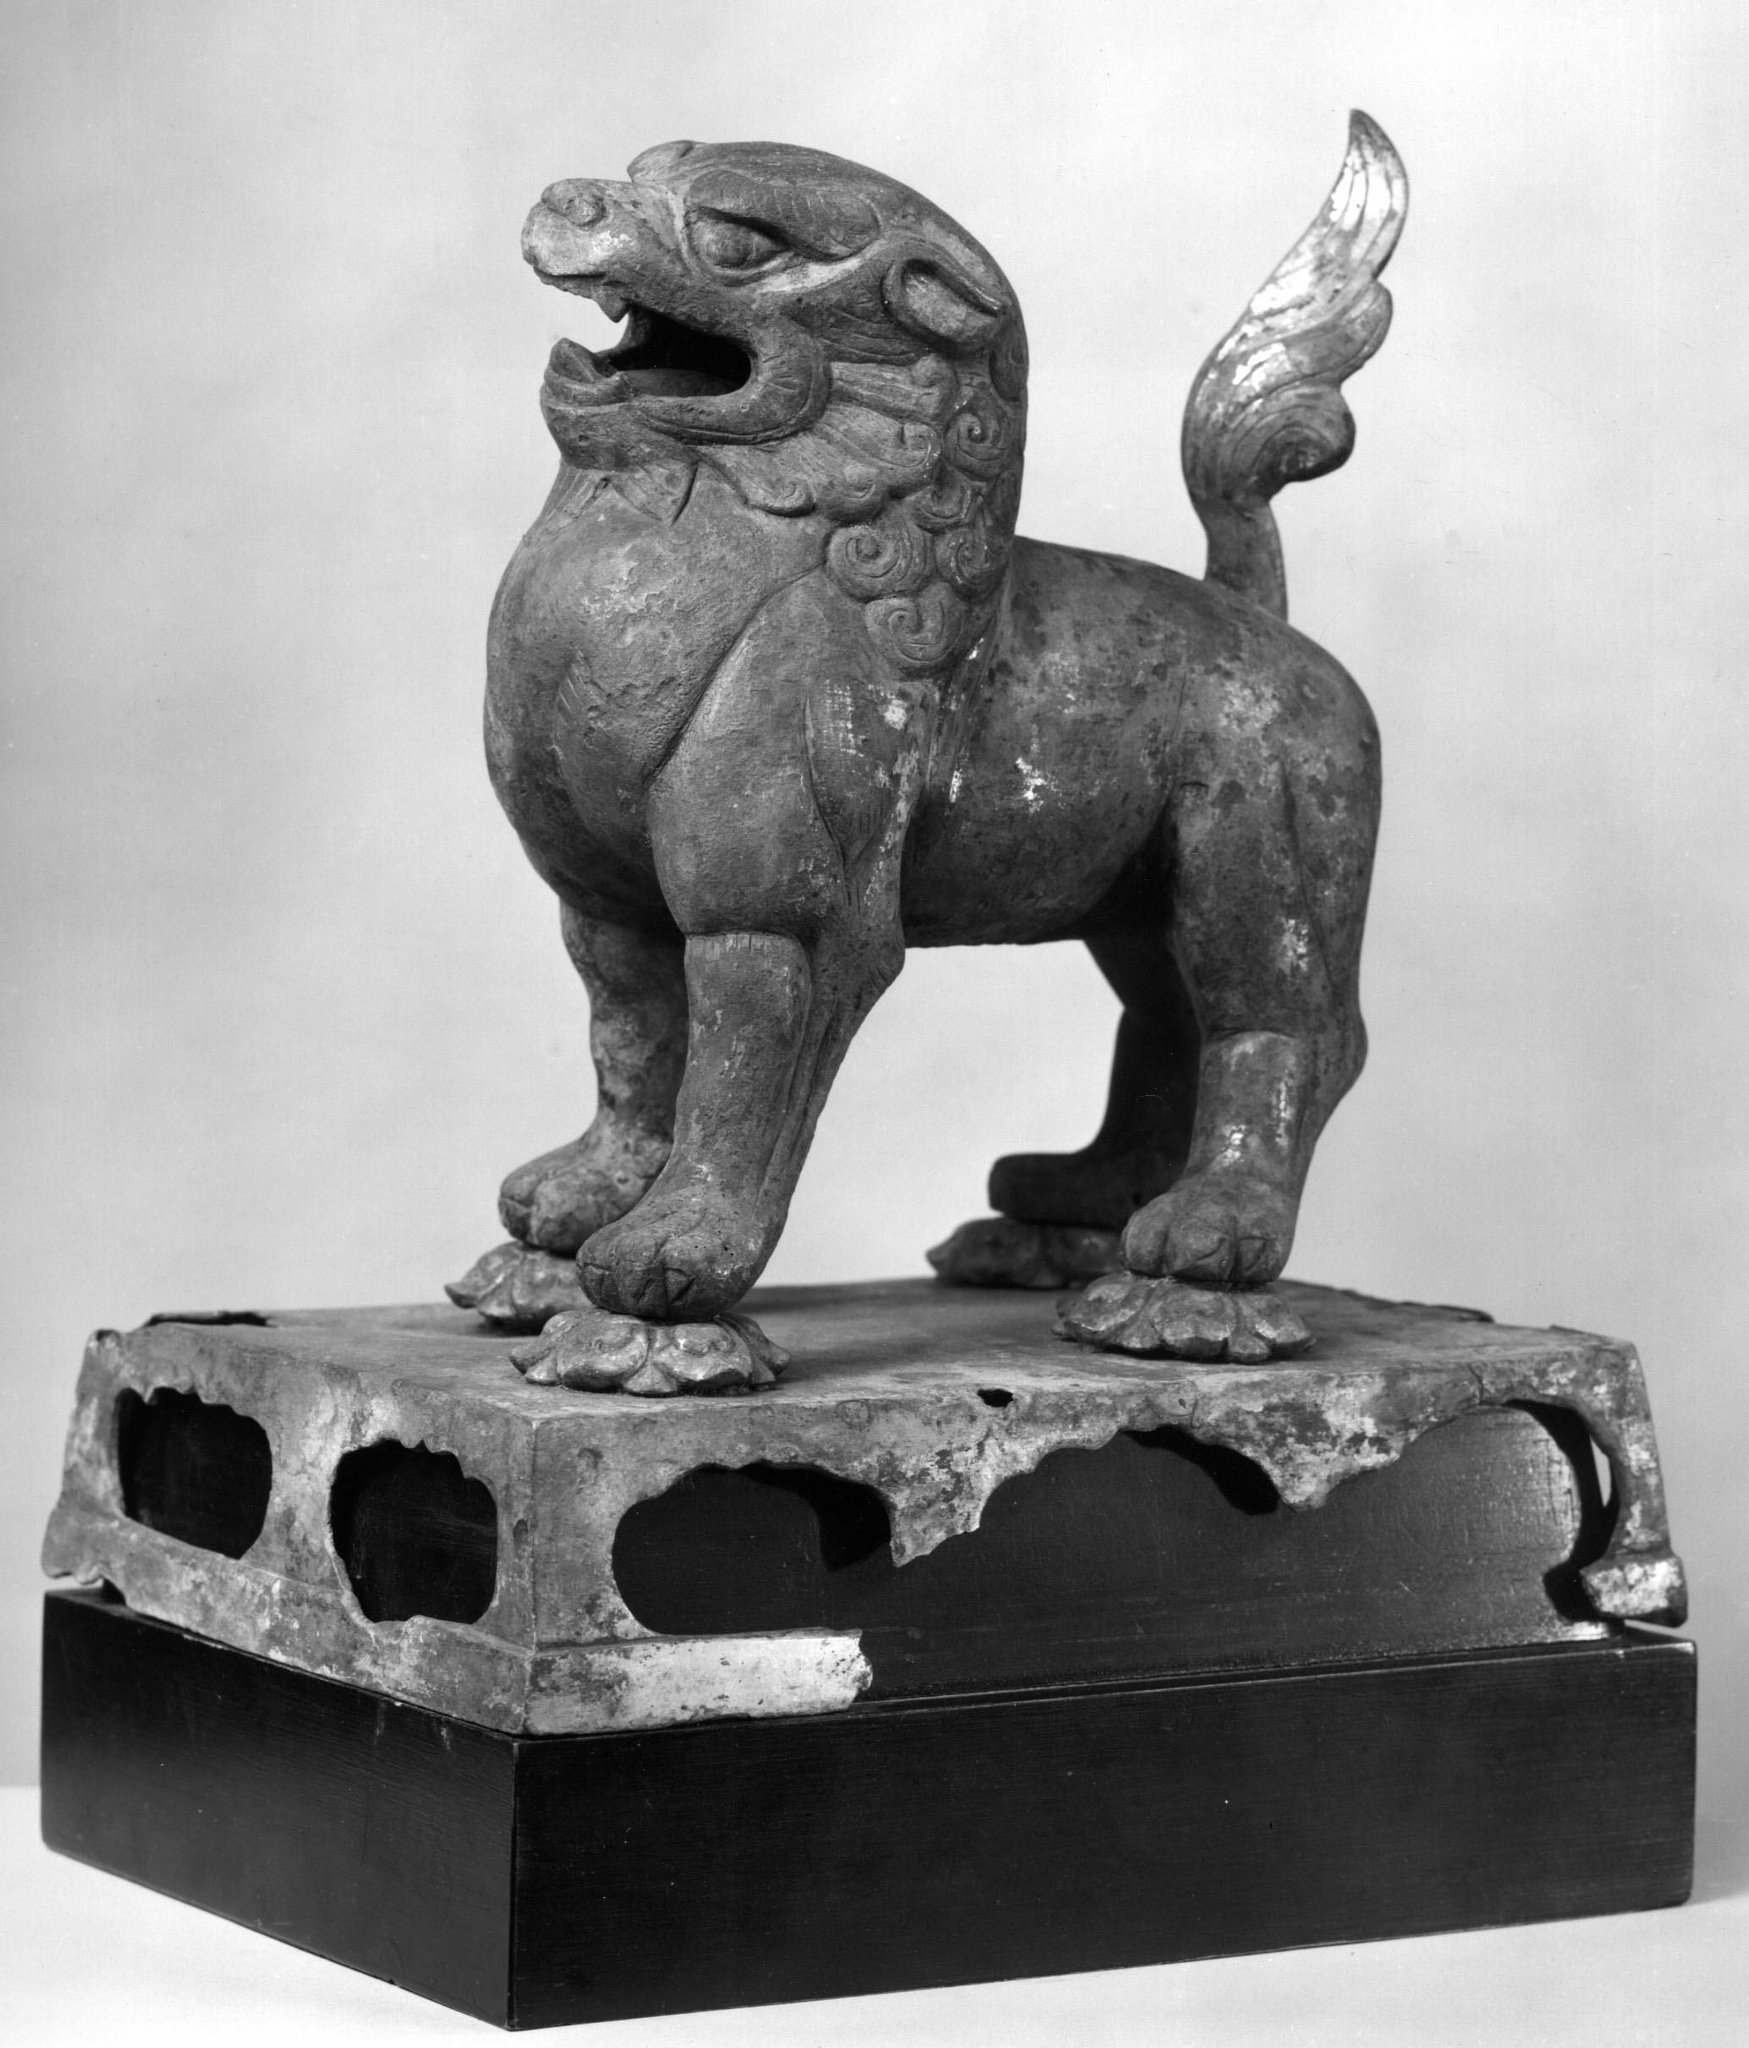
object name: statuette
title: Lion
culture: chinese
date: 701-800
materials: bronze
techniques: gilding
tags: lions